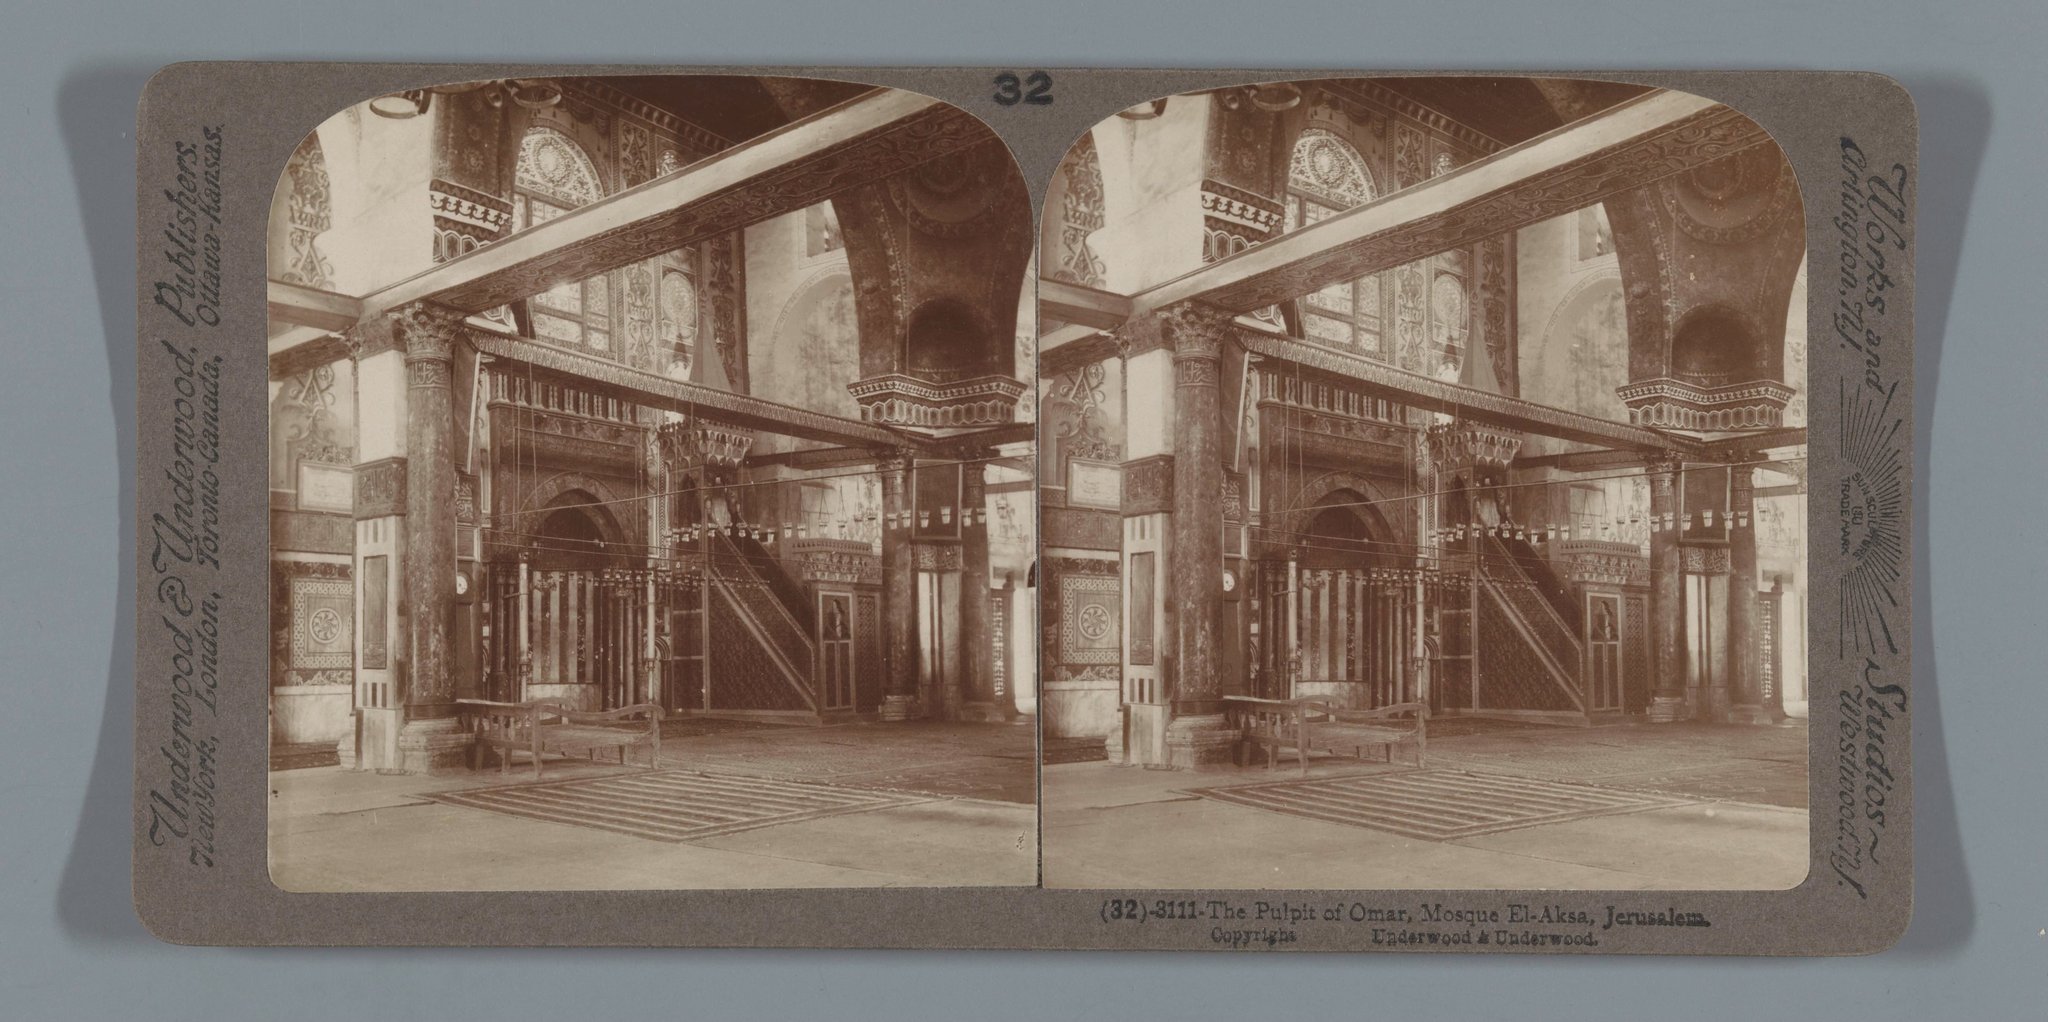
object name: stereograph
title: The Pulpit of Omar, Mosque El-Aksa, Jerusalem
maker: Anonymous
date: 1900-1905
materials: paper, cardboard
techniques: gelatin silver print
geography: jerusalem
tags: pulpit, ambo, chancel, temple, shrine ~ islam, mohammedanism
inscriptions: inscription, number: ‘(32)-3111-’, inscription: ‘Works and Studios ~/ Arlington, N.J. Westwood, N.J.’, copyright notice: ‘Copyright Underwood & Underwood.’, number: ‘32’